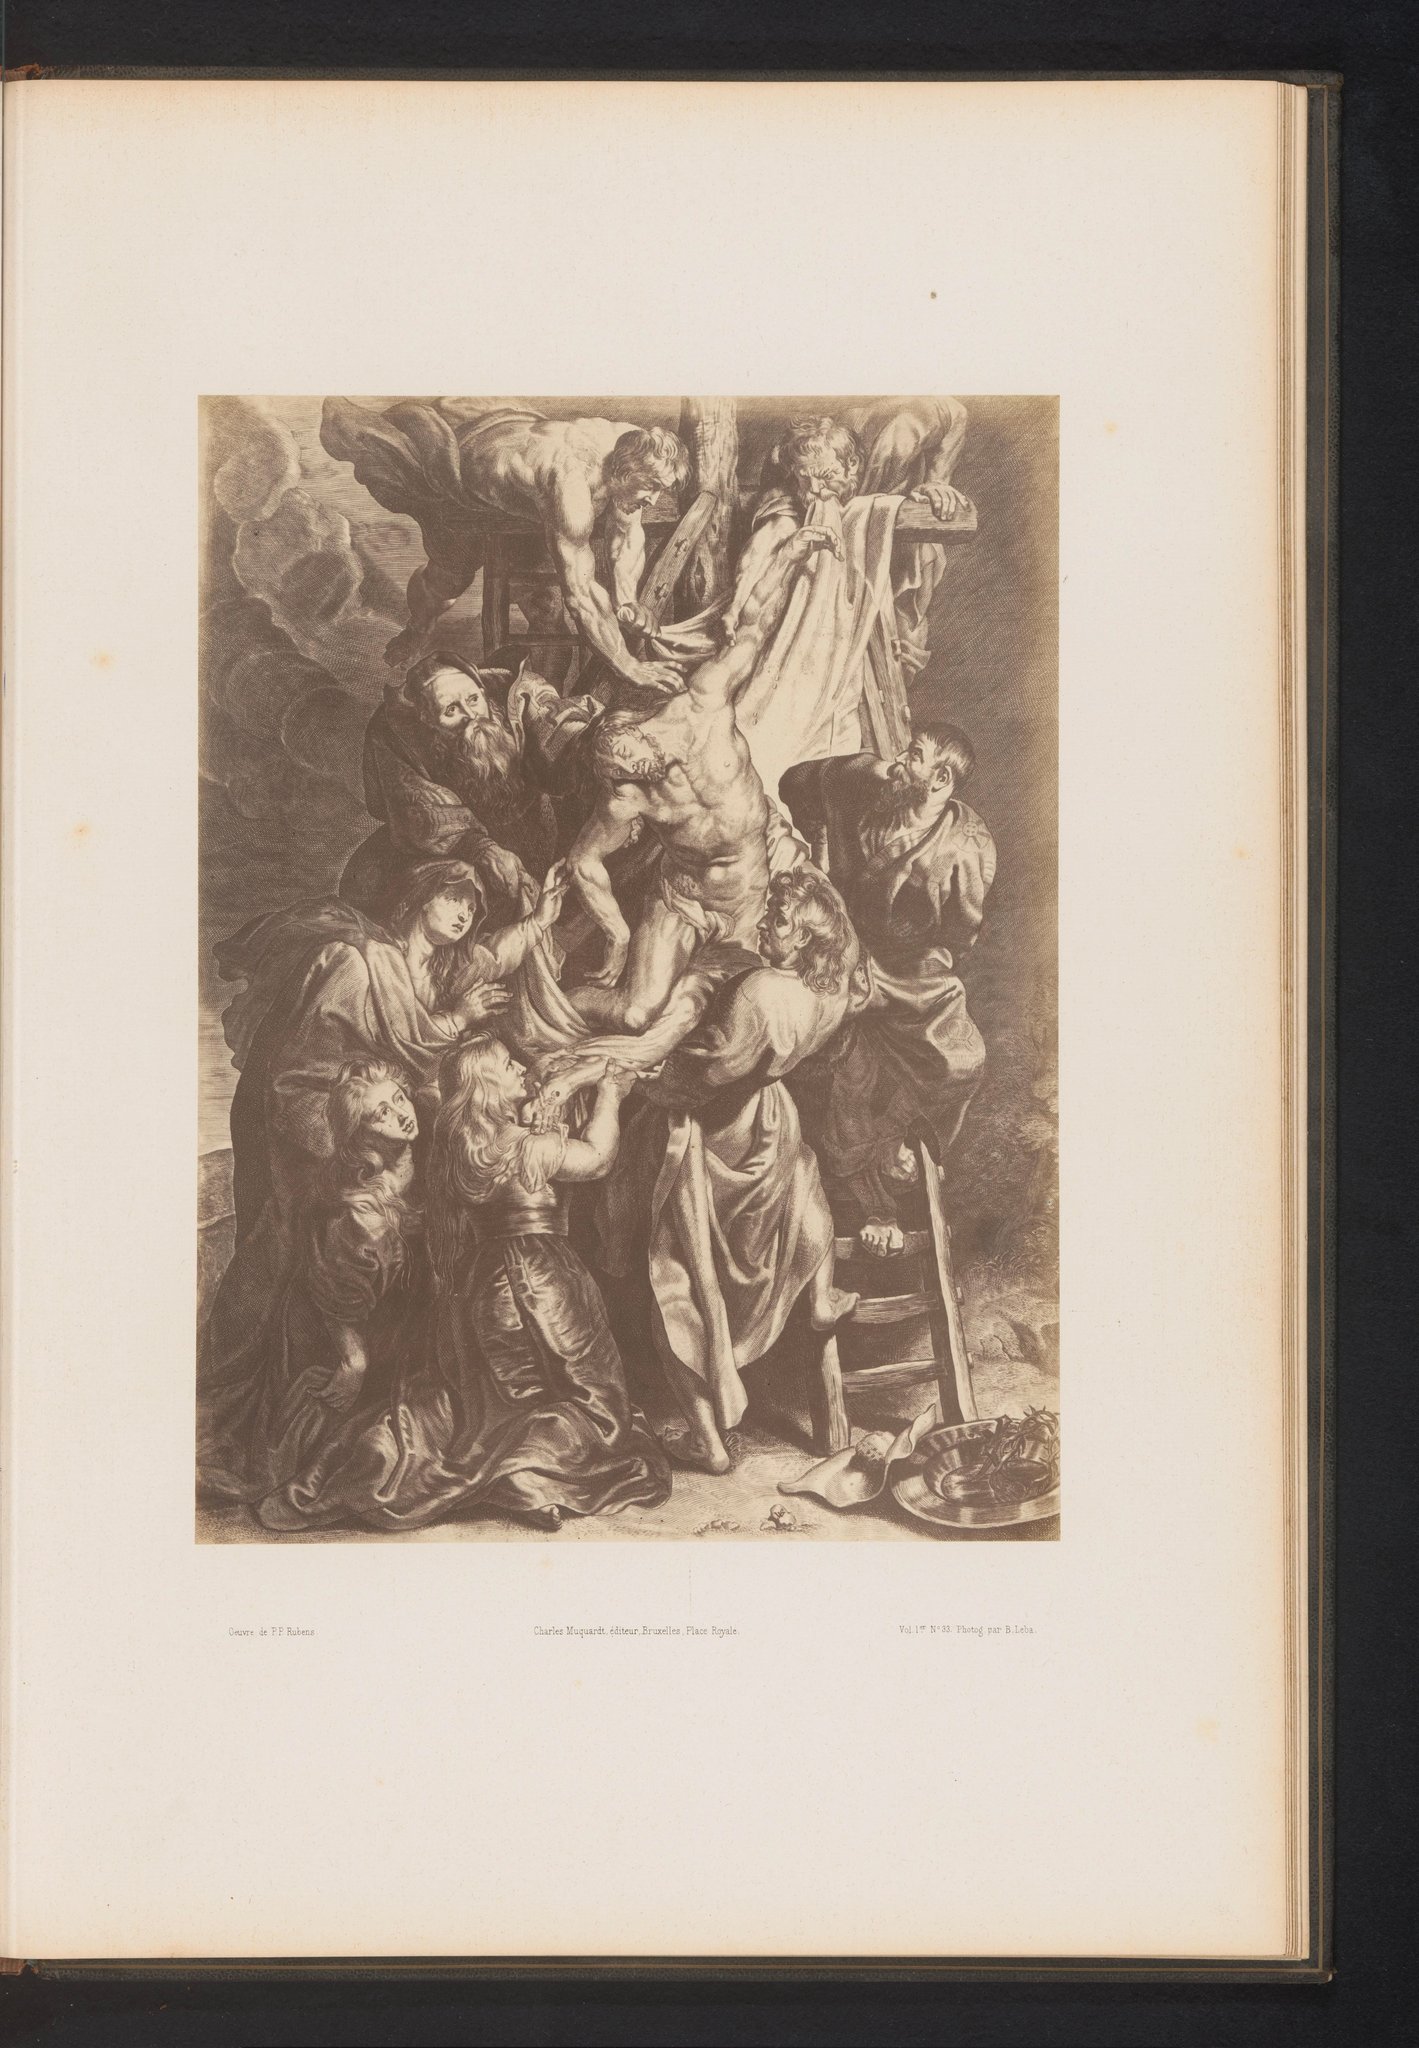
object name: page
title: Fotoreproductie van een gravure van De kruisafneming door Lucas Vorsterman, naar het schilderij door Peter Paul Rubens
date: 1853-1858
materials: photographic support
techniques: albumen print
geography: brussels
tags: descent from the cross: christ is taken down from the cross, usually by nicodemus and joseph of arimathaea who are standing on the ladders (both arms of christ detached)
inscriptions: number: ‘Vol. 1er. No 33.’